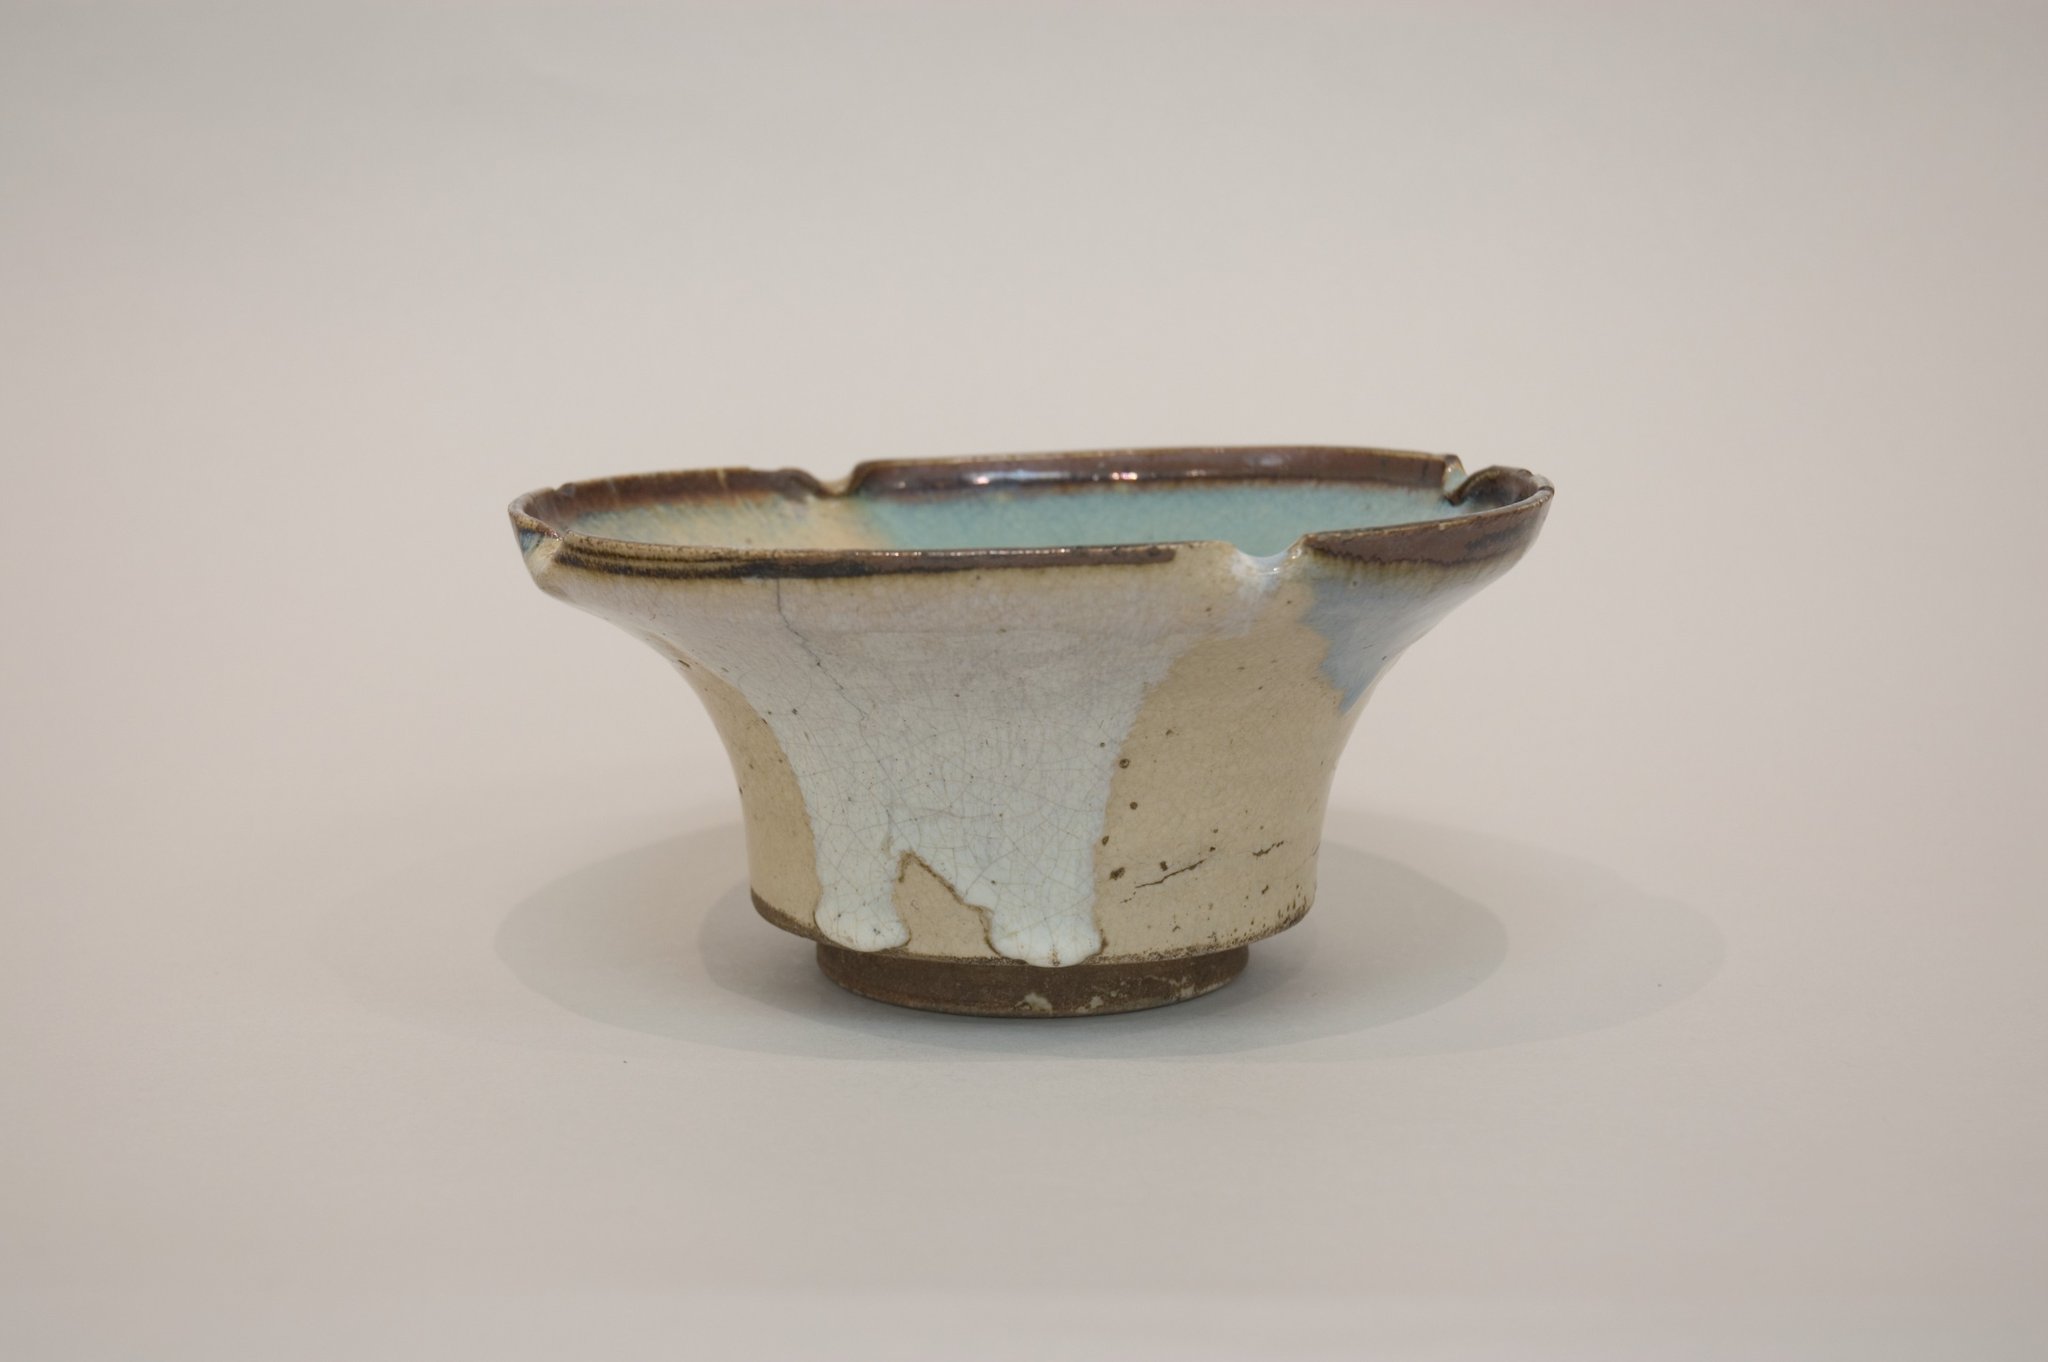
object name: bowl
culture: japanese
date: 1801-1900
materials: clay, glaze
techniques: polychrome